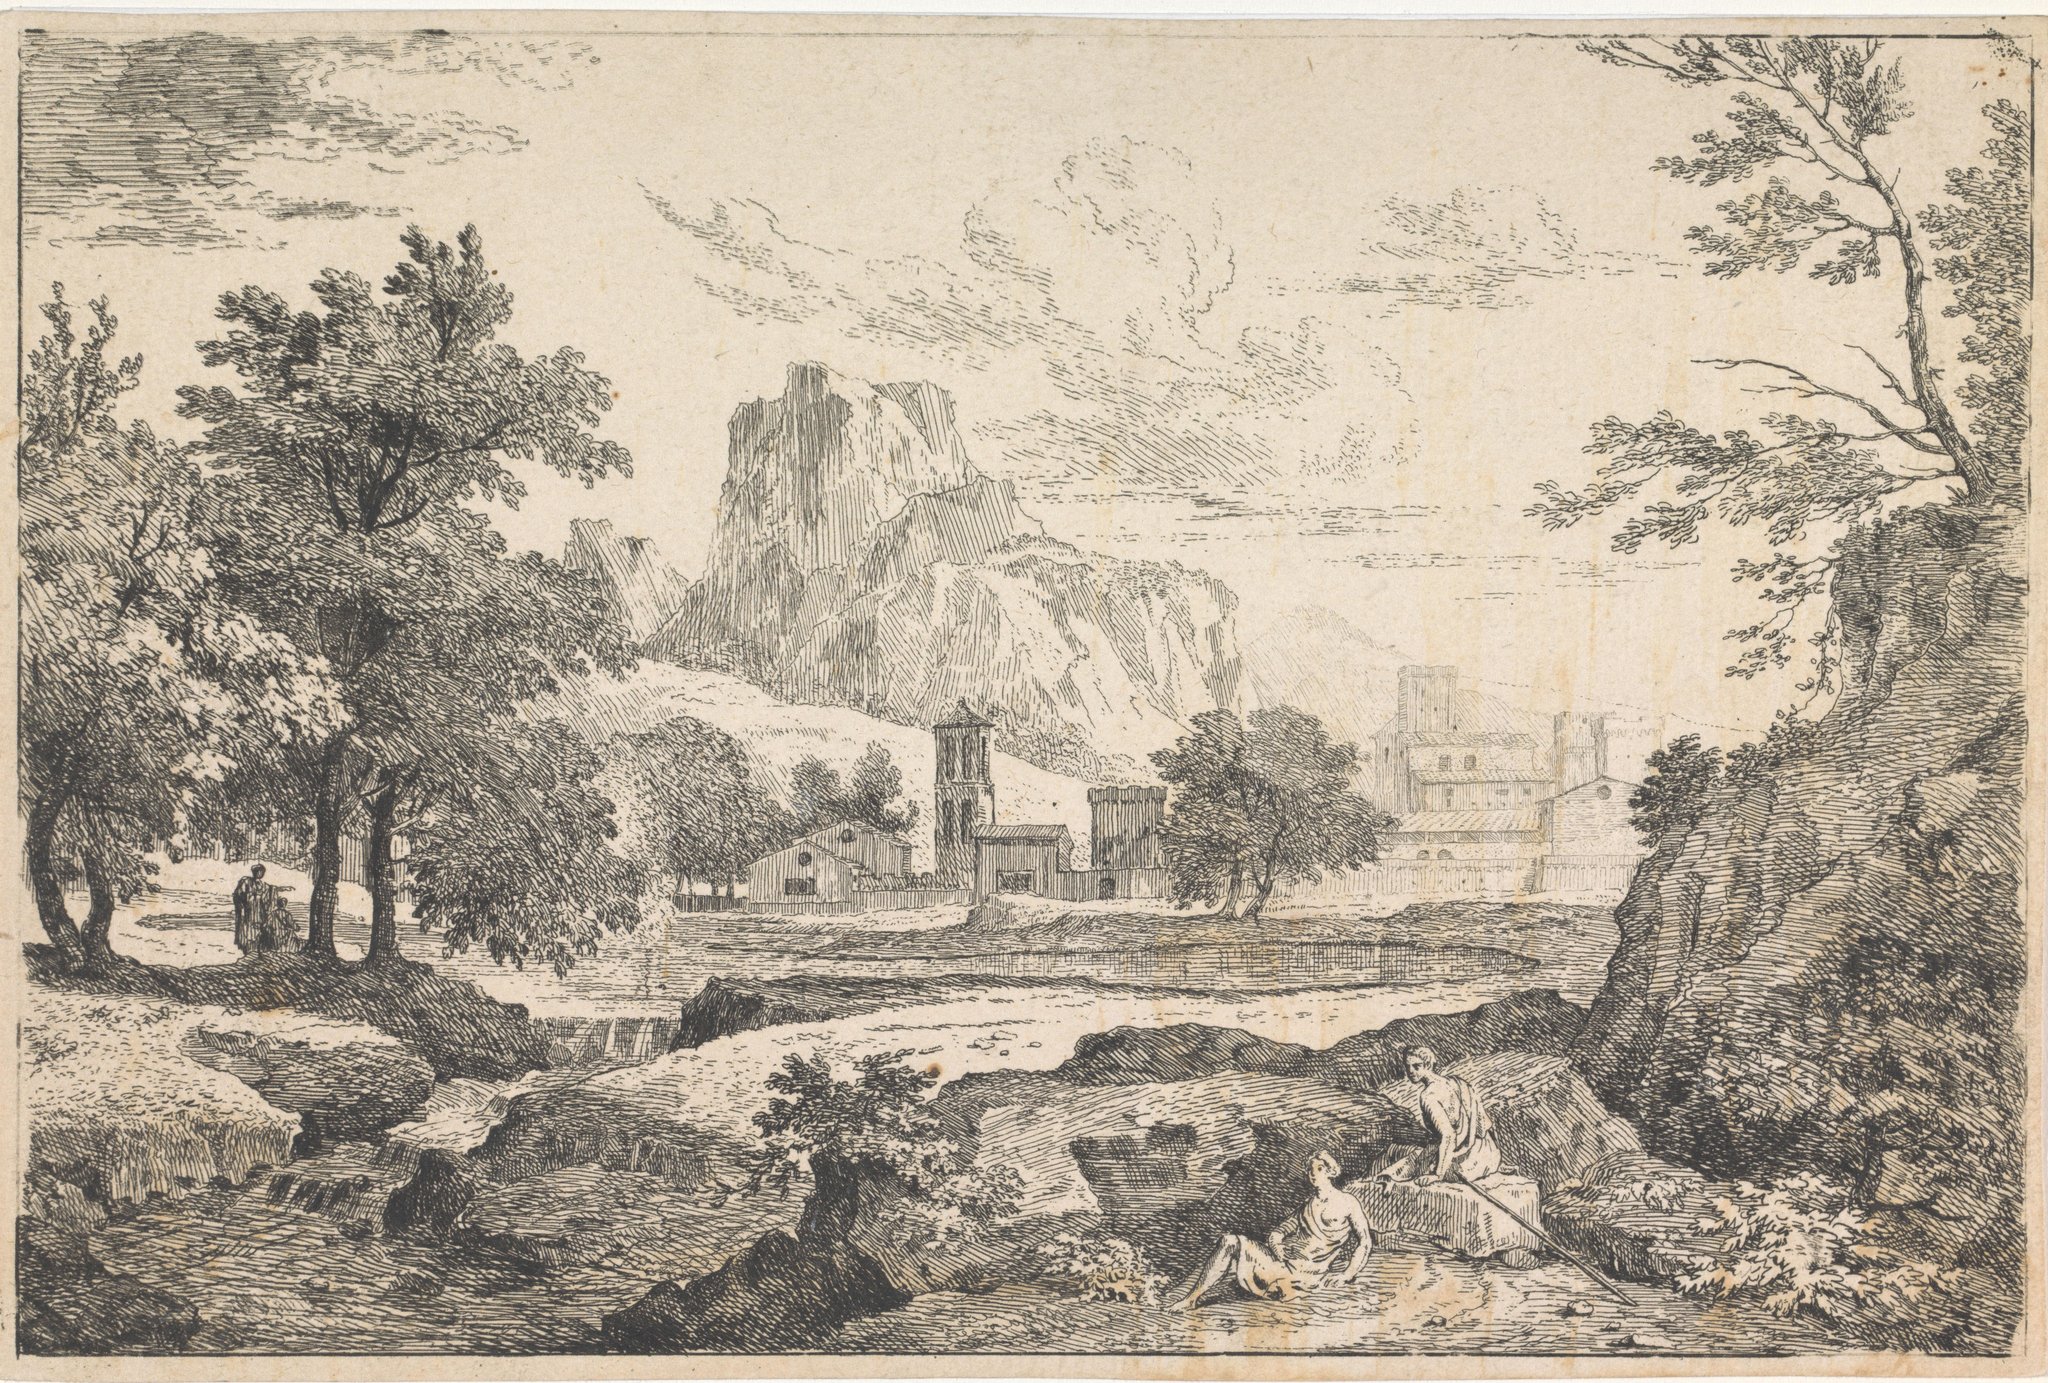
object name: print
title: Arcadisch landschap met een herder en herderin op de voorgrond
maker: Anonymous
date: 1700-1800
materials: paper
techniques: etching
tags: pastorals, arcadian scenes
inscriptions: collector's mark: Lugt 2228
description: Arcadisch landschap met een herder en herderin op de voorgrond. Op de achtergrond gebouwen.